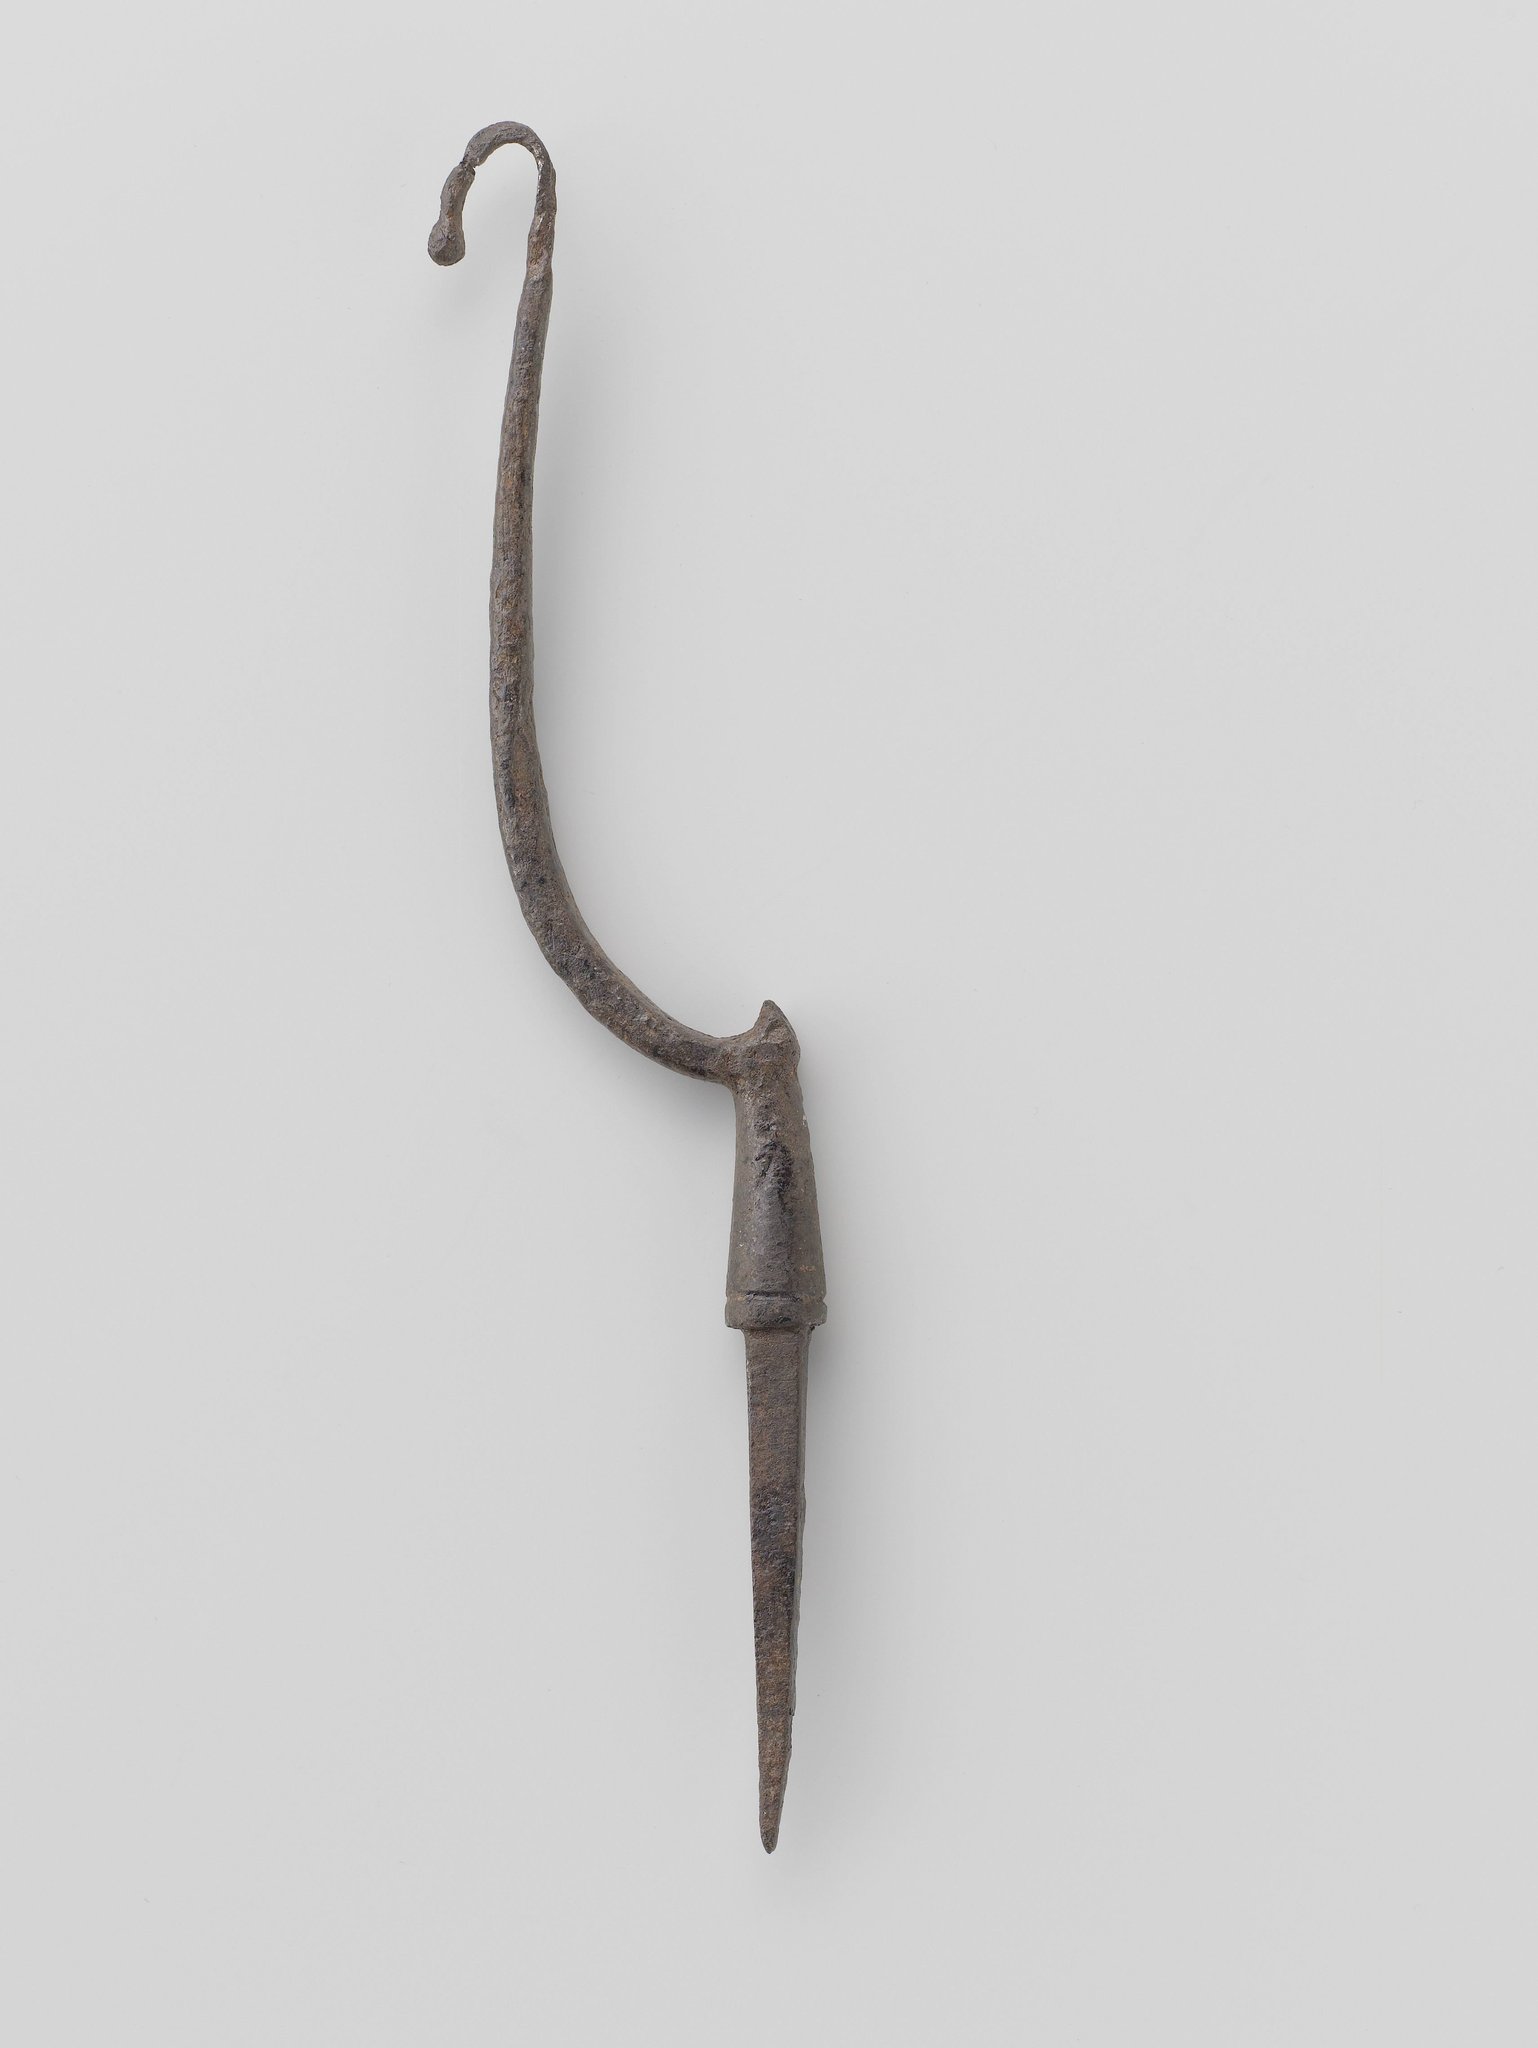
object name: furket, musketvork, forket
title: Musketvork, een arm ontbreekt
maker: Anonymous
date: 1590-1596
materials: iron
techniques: forging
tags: willem barendsz., amsterdam, jacob van heemskerck